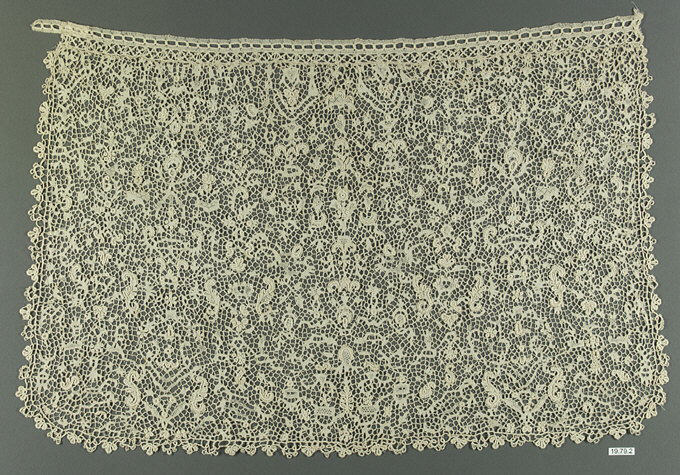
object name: cravat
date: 1701-1800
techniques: lace